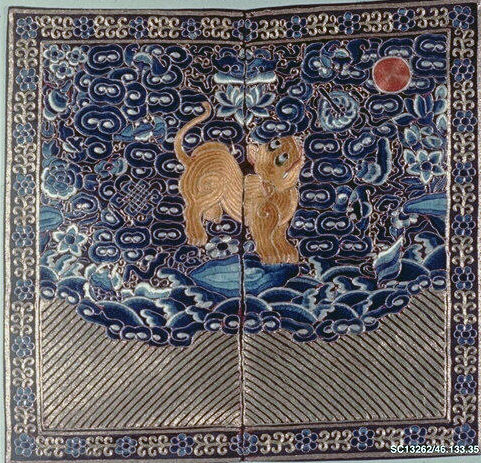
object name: rank badge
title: Rank Badge with Tiger Cat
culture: chinese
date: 1801-1833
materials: gold, silk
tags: cats